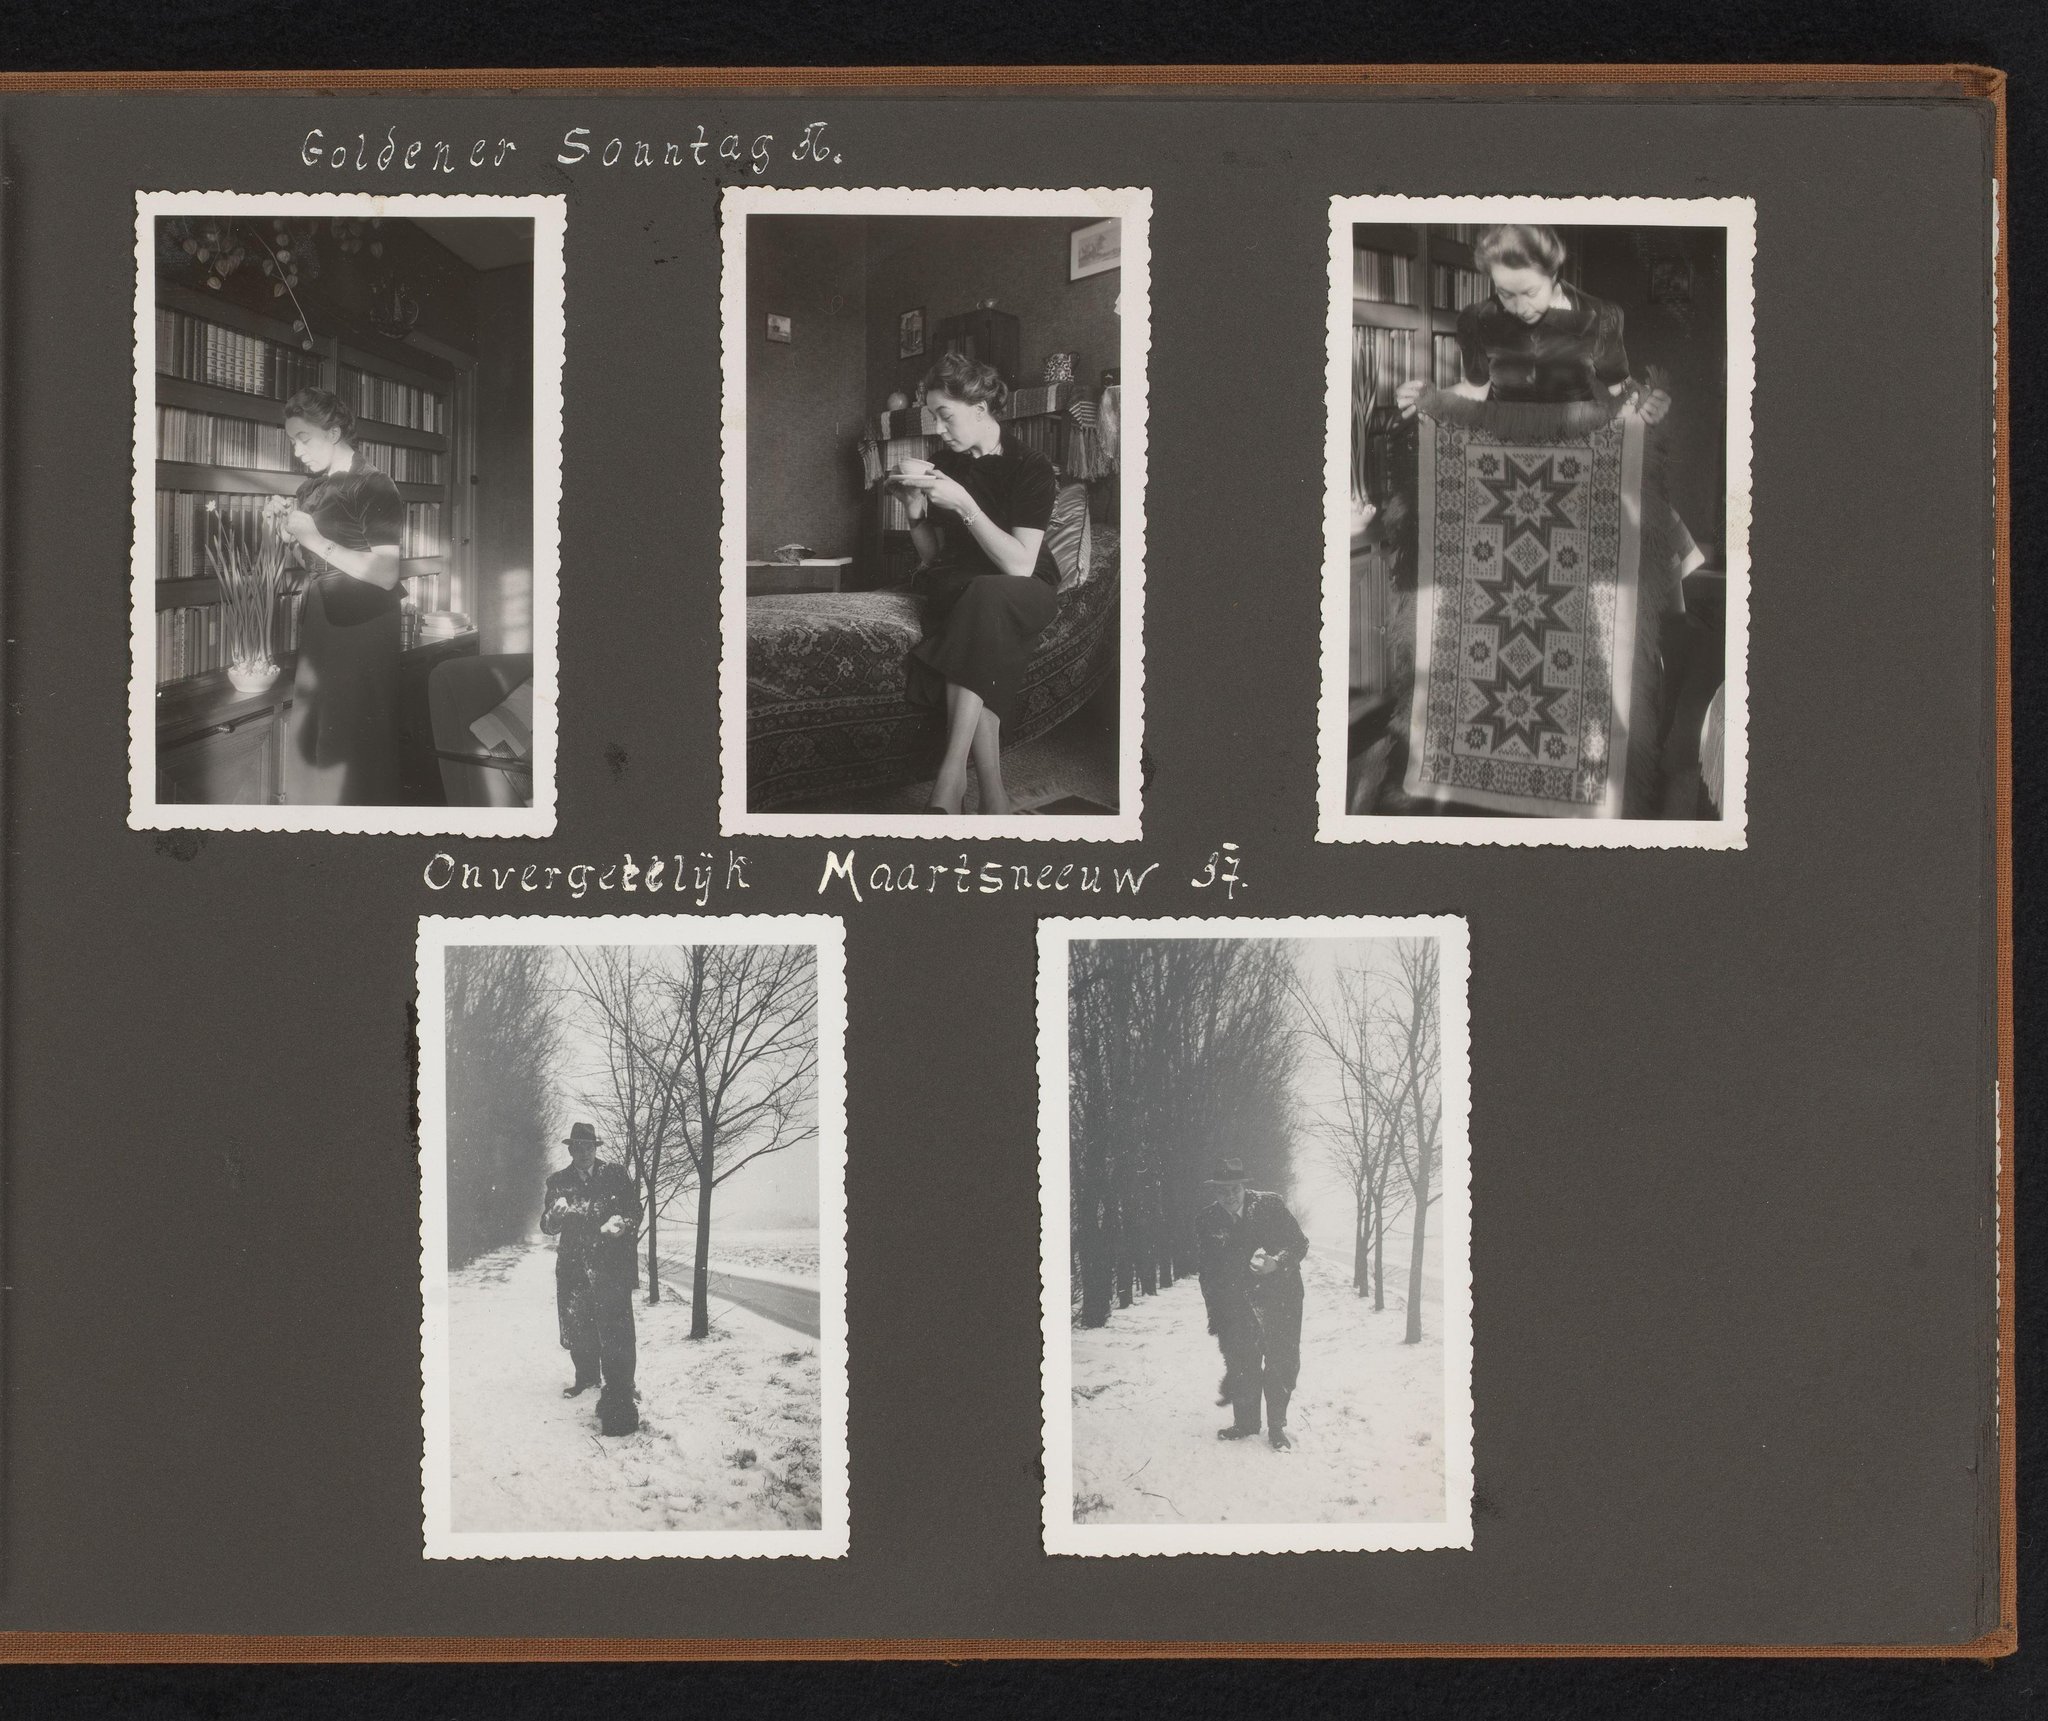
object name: album leaf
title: Berti Hoppe thuis en Herman Besselaar in de sneeuw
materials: cardboard, paper, photographic support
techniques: gelatin silver print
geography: rotterdam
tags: herman besselaar, berti hoppe, historical persons - bb - woman, historical persons, walking the dog, interior of the house, rotterdam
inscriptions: date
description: Vijf foto's van Berti Hoppe en Herman Besselaar in en rond het huis. Deze pagina maakt deel uit van een album.